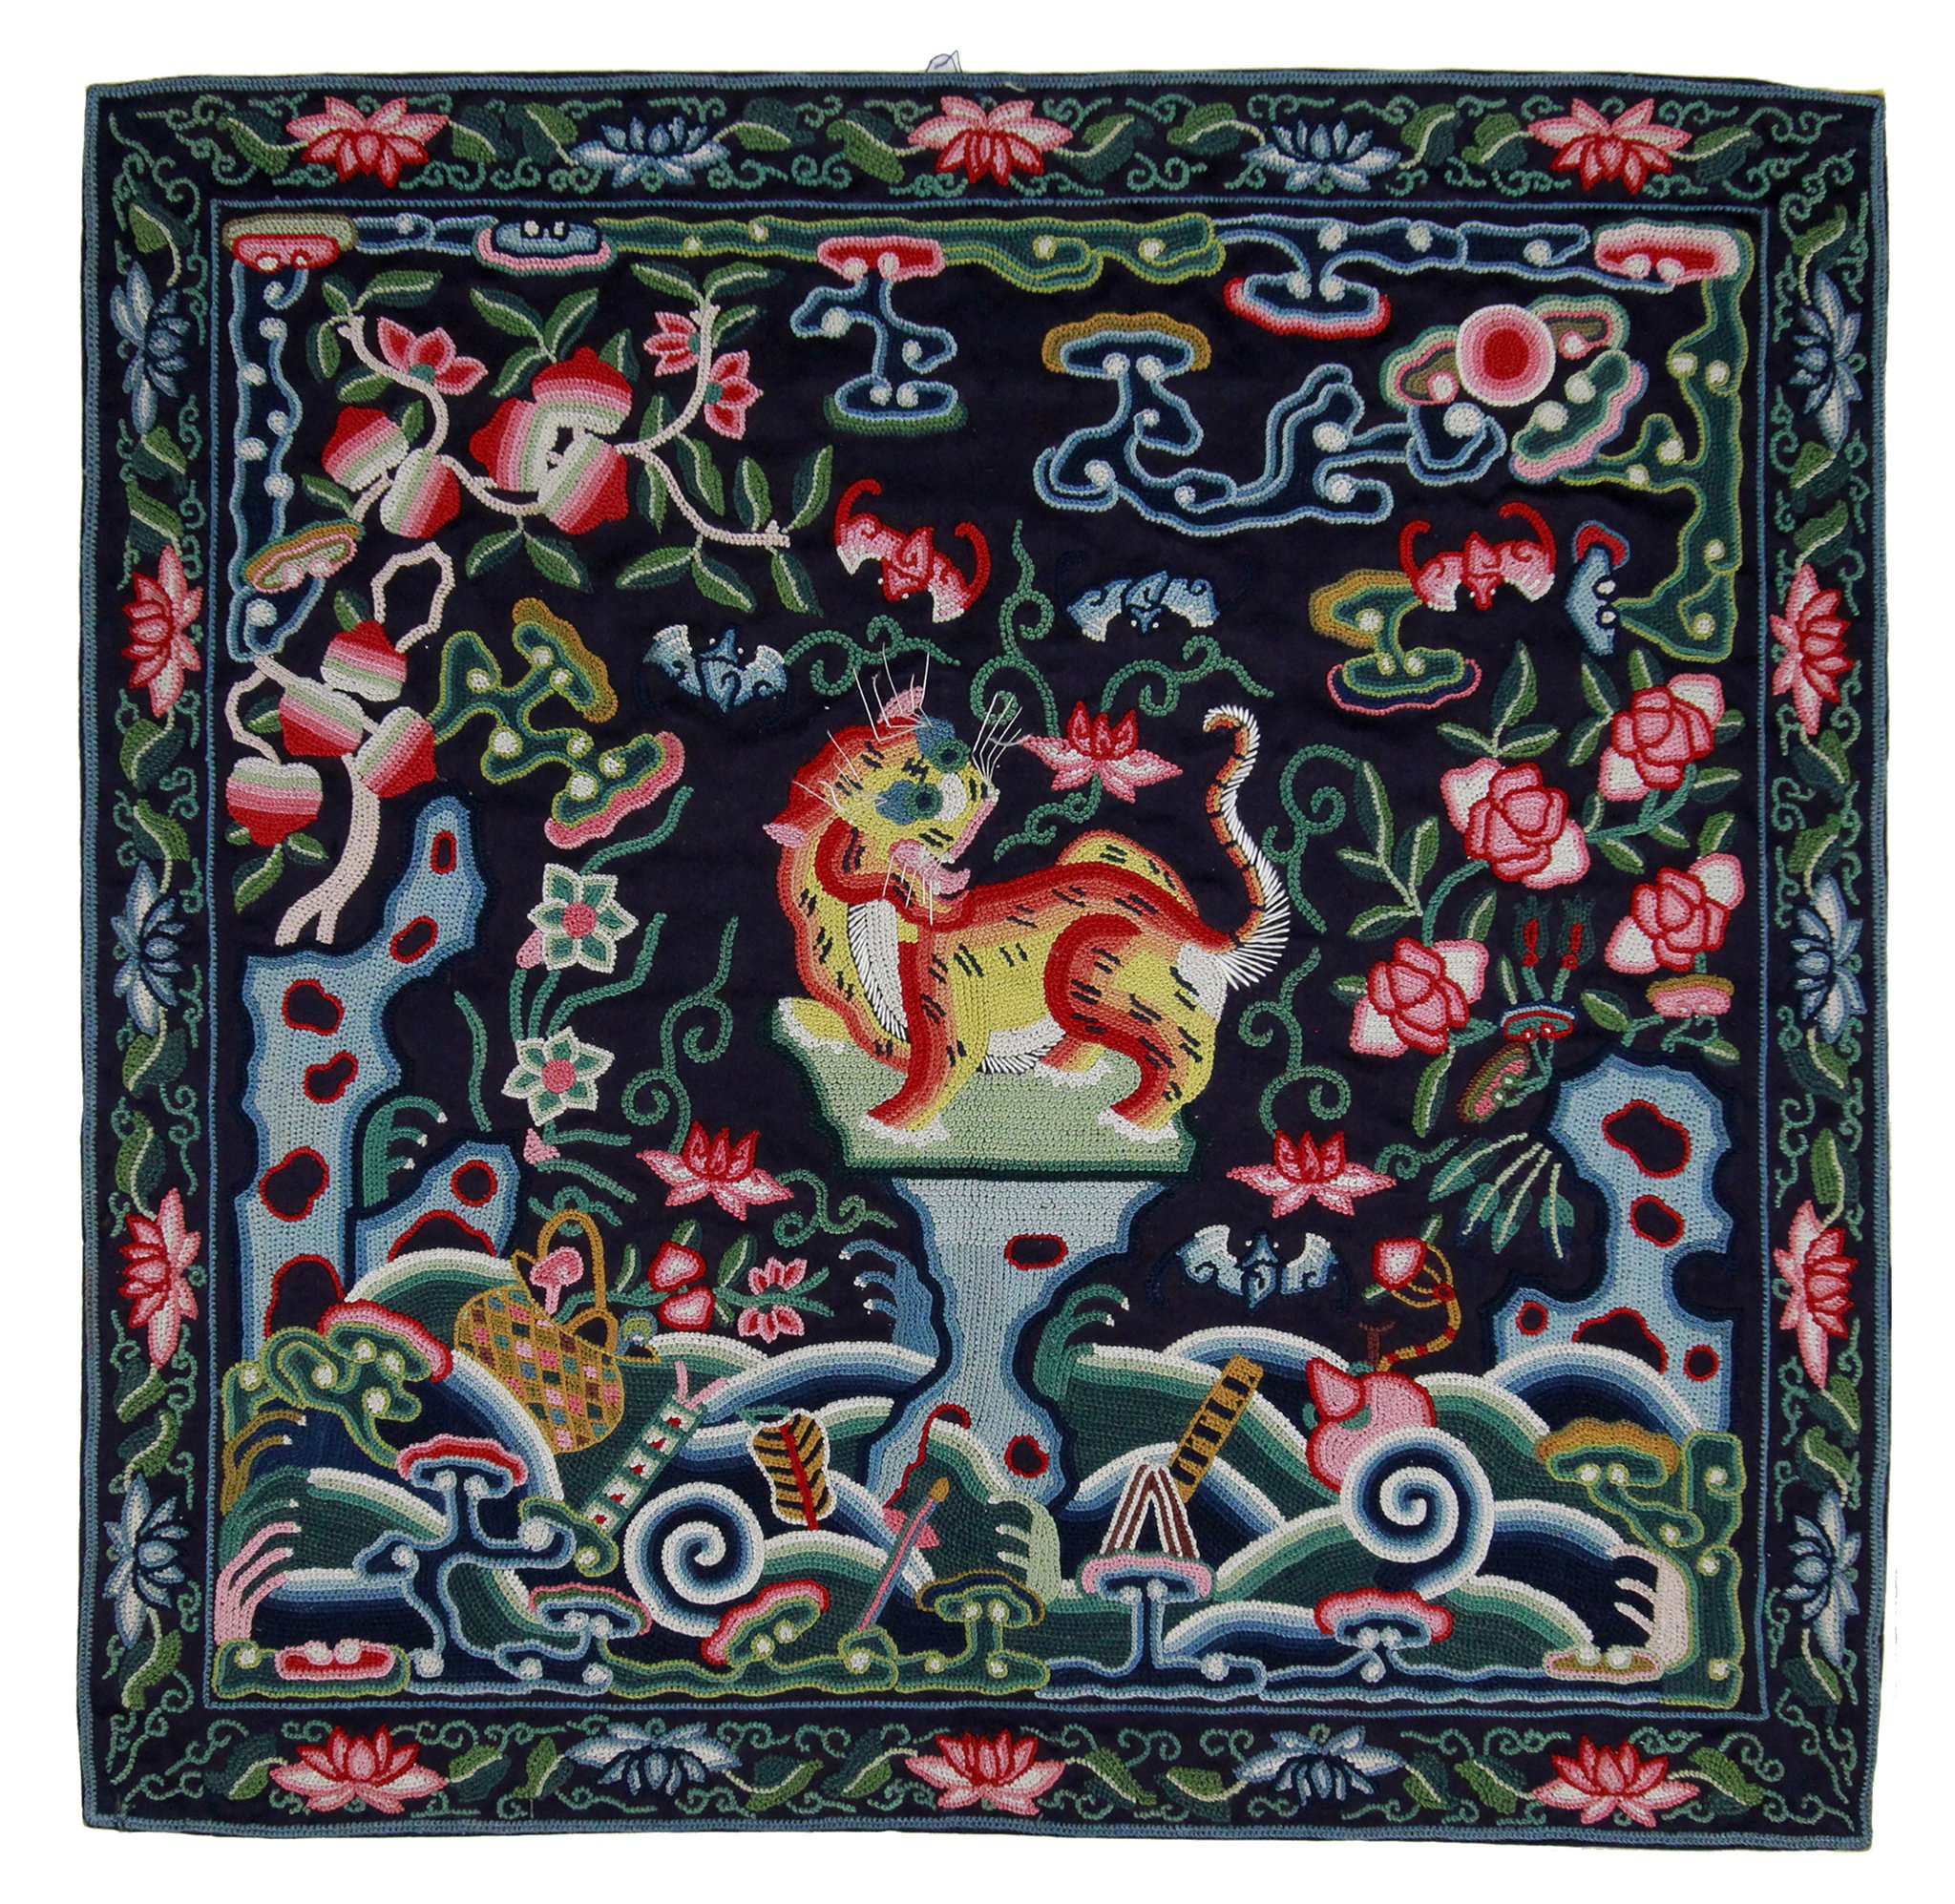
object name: rank badge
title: Rank badge with tiger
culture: chinese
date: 1767-1800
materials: silk, thread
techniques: embroidery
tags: bats,tigers